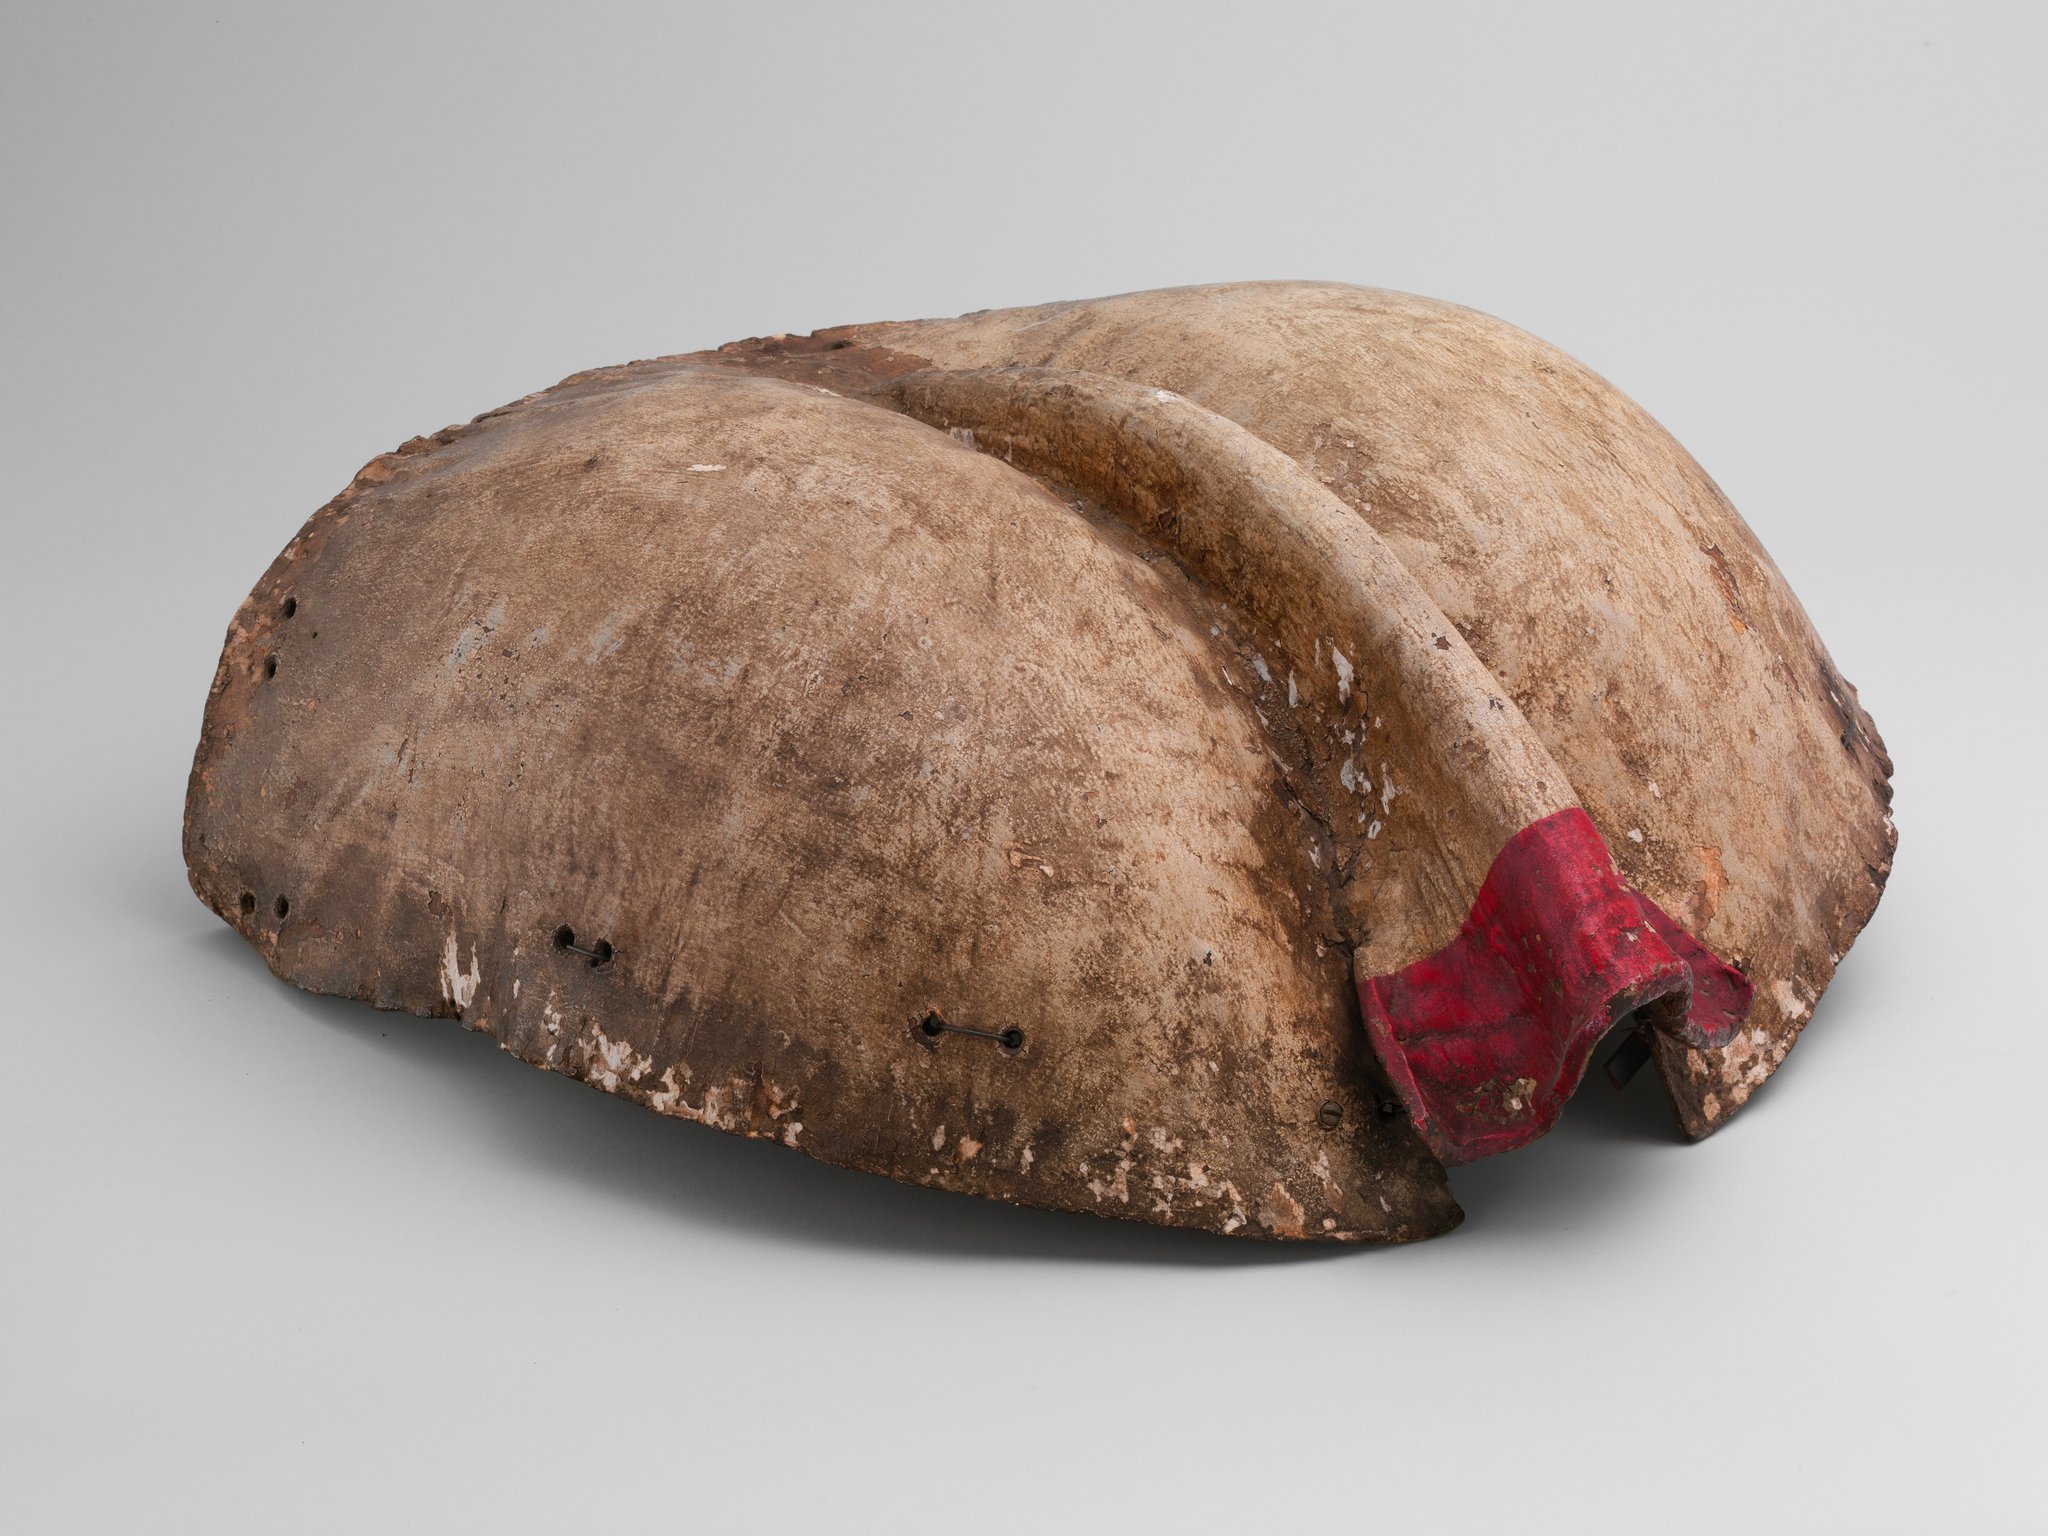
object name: crupper plate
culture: flemish or german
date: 1501-1533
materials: gesso, leather, paint